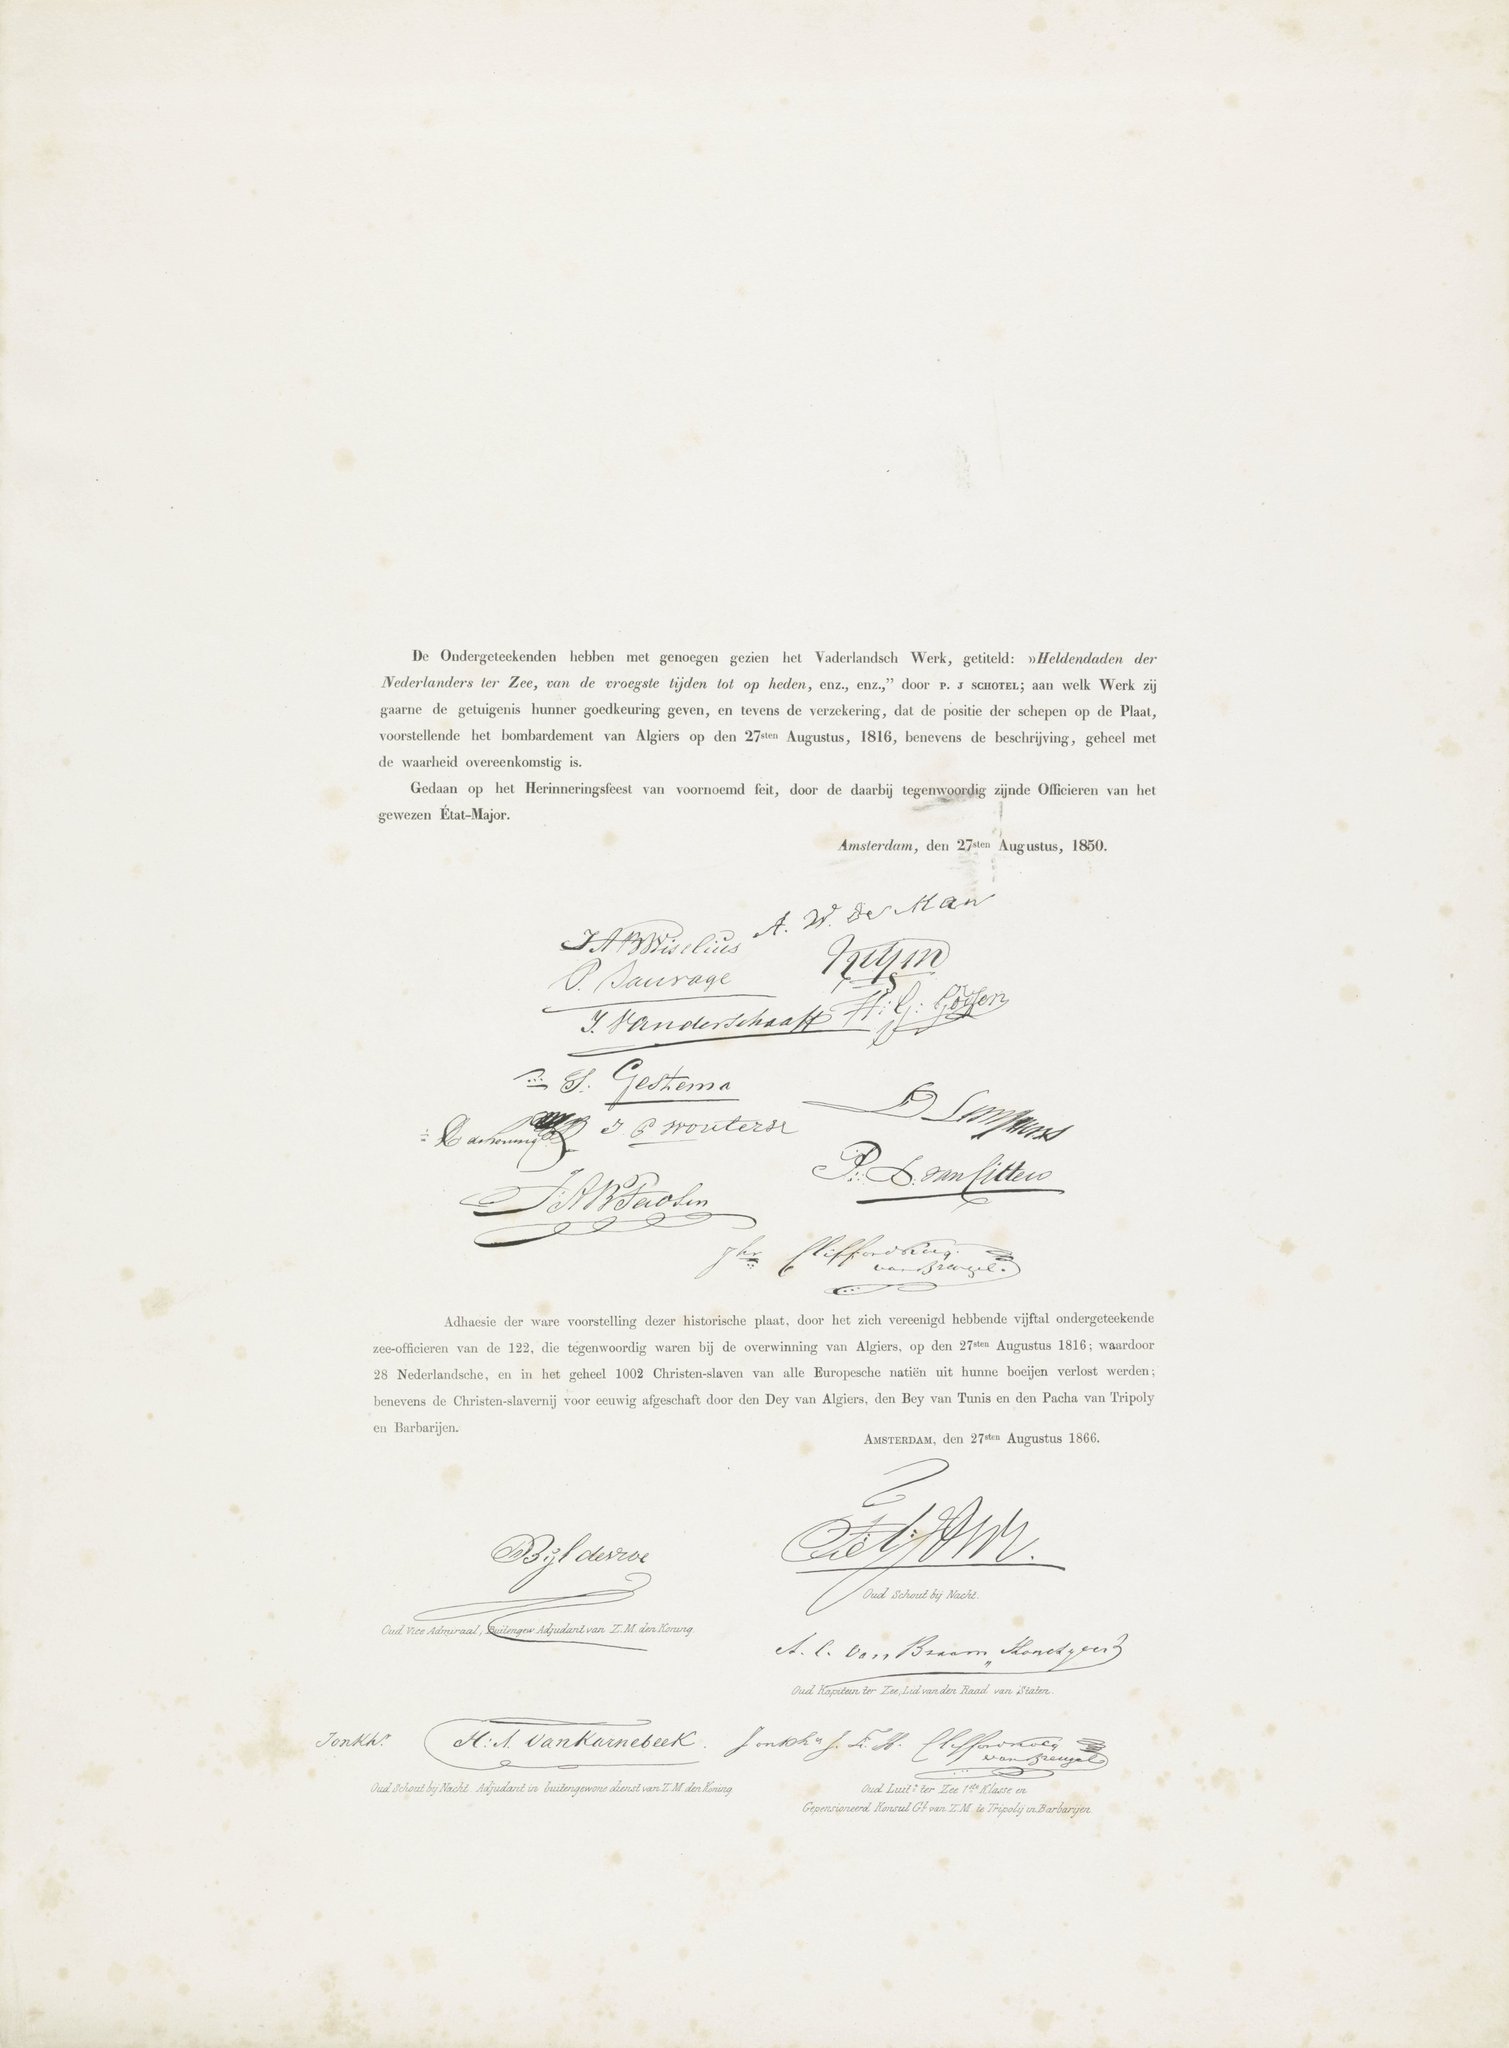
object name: print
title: Blad met namen bij de herdenking van het Bombardement van Algiers (1816) in 1850 en 1866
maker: Anonymous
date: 1866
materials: paper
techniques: lithograph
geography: netherlands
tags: handwriting, written text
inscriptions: collector's mark: Lugt 2228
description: Blad met de namen en handtekeningen van een groep personen die verklaren dat de voorstelling van het bombardement van Algiers in de nacht van 26-27 augustus 1816 door de gecombineerde Engels-Nederlandse vloot met de waarheid overeenkomstig is, gedaan op het Herinneringsfeest te Amsterdam op 27 augustus 1850. Daaronder op hetzelfde blad de namen en handtekeningen van een vijftal zeeofficieren die aanwezig waren bij het bombardement en de daaropvolgende bevrijding van 1002 gevangen genomen zeelieden en vissers, waaronder 28 Nederlanders, uit Algiers. Deze tweede groep namen bij de vijftigjarige herdenking van het bombardement op 27 augustus 1866 te Amsterdam